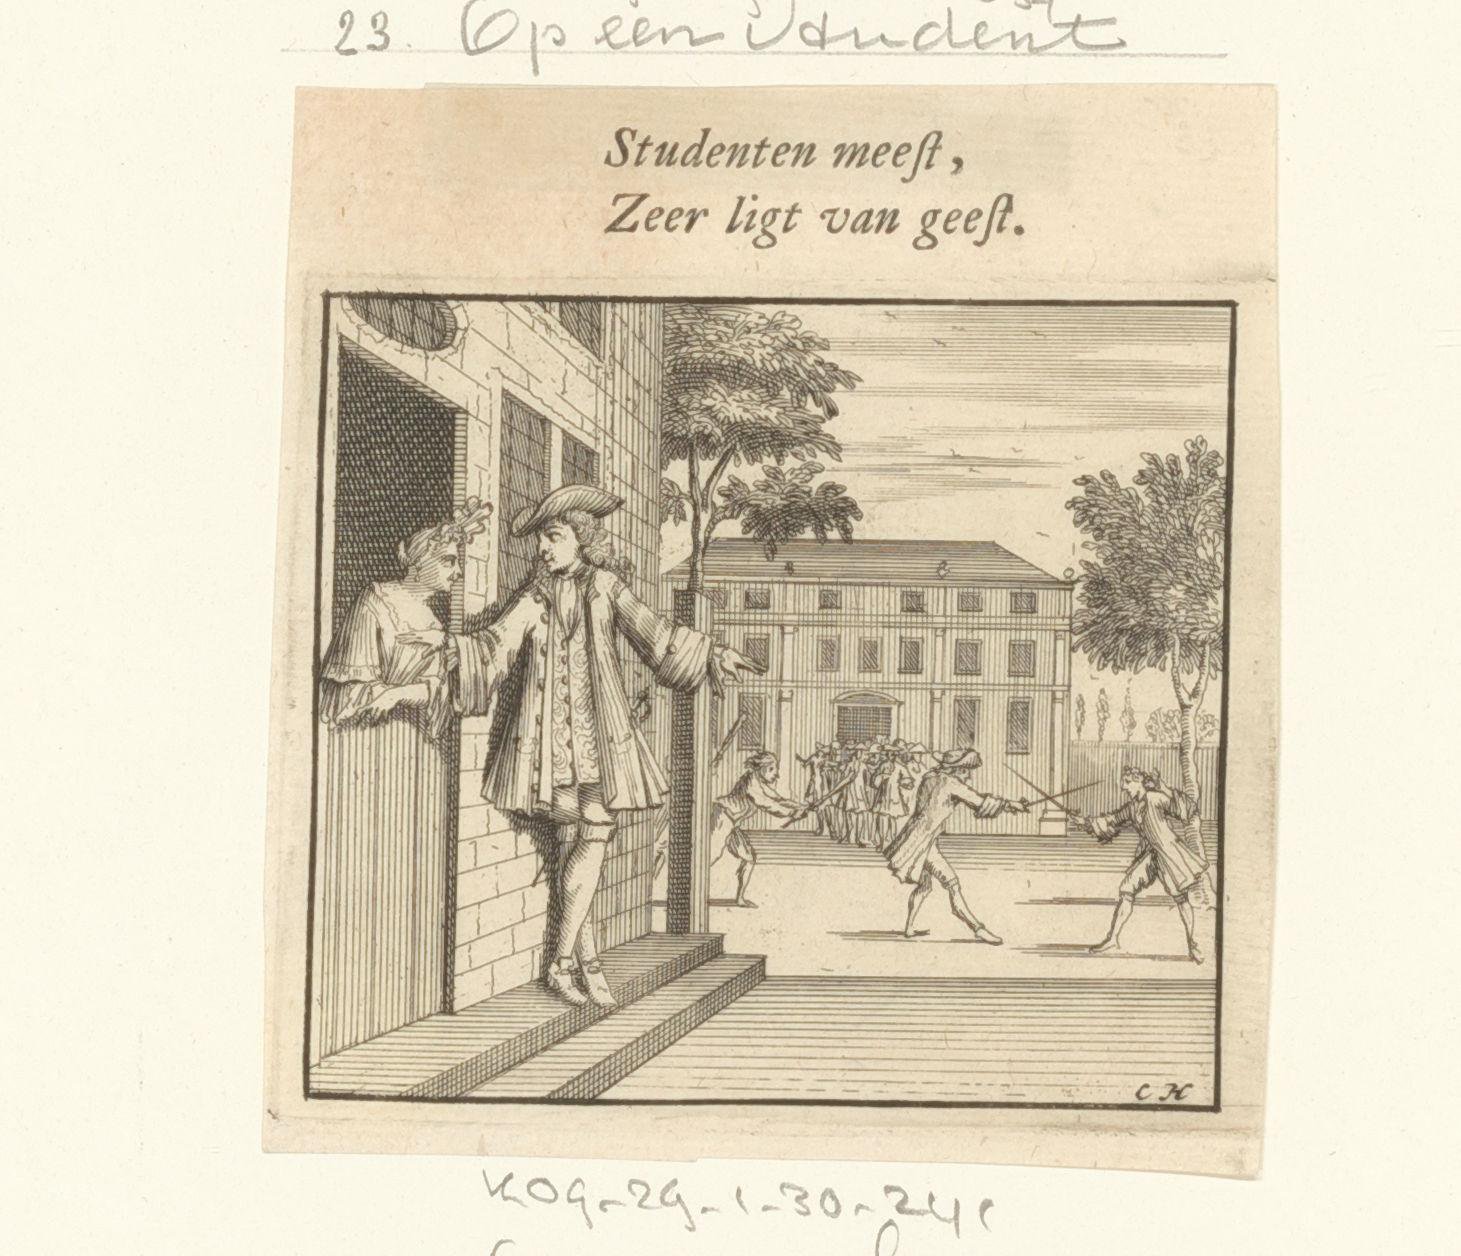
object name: print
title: Twee koopmannen bekijken de lading van een schip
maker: cornelis huyberts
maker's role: print maker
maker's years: 1669-1709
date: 1725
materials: paper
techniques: etching, letterpress printing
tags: student life, fencing (sport)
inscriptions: stamp, collector's mark: Lugt 1641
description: Prent uit: Graauwhart, Hendrik. Voorbeeldelyke zeede-lessen, genoomen uyt den eersten toestand des werelds (...). Amsterdam: Johannes Ratelband, 1725. Prent ook gebruikt voor eerdere en (1709) latere uitgave (1756, 1761 en 1764).